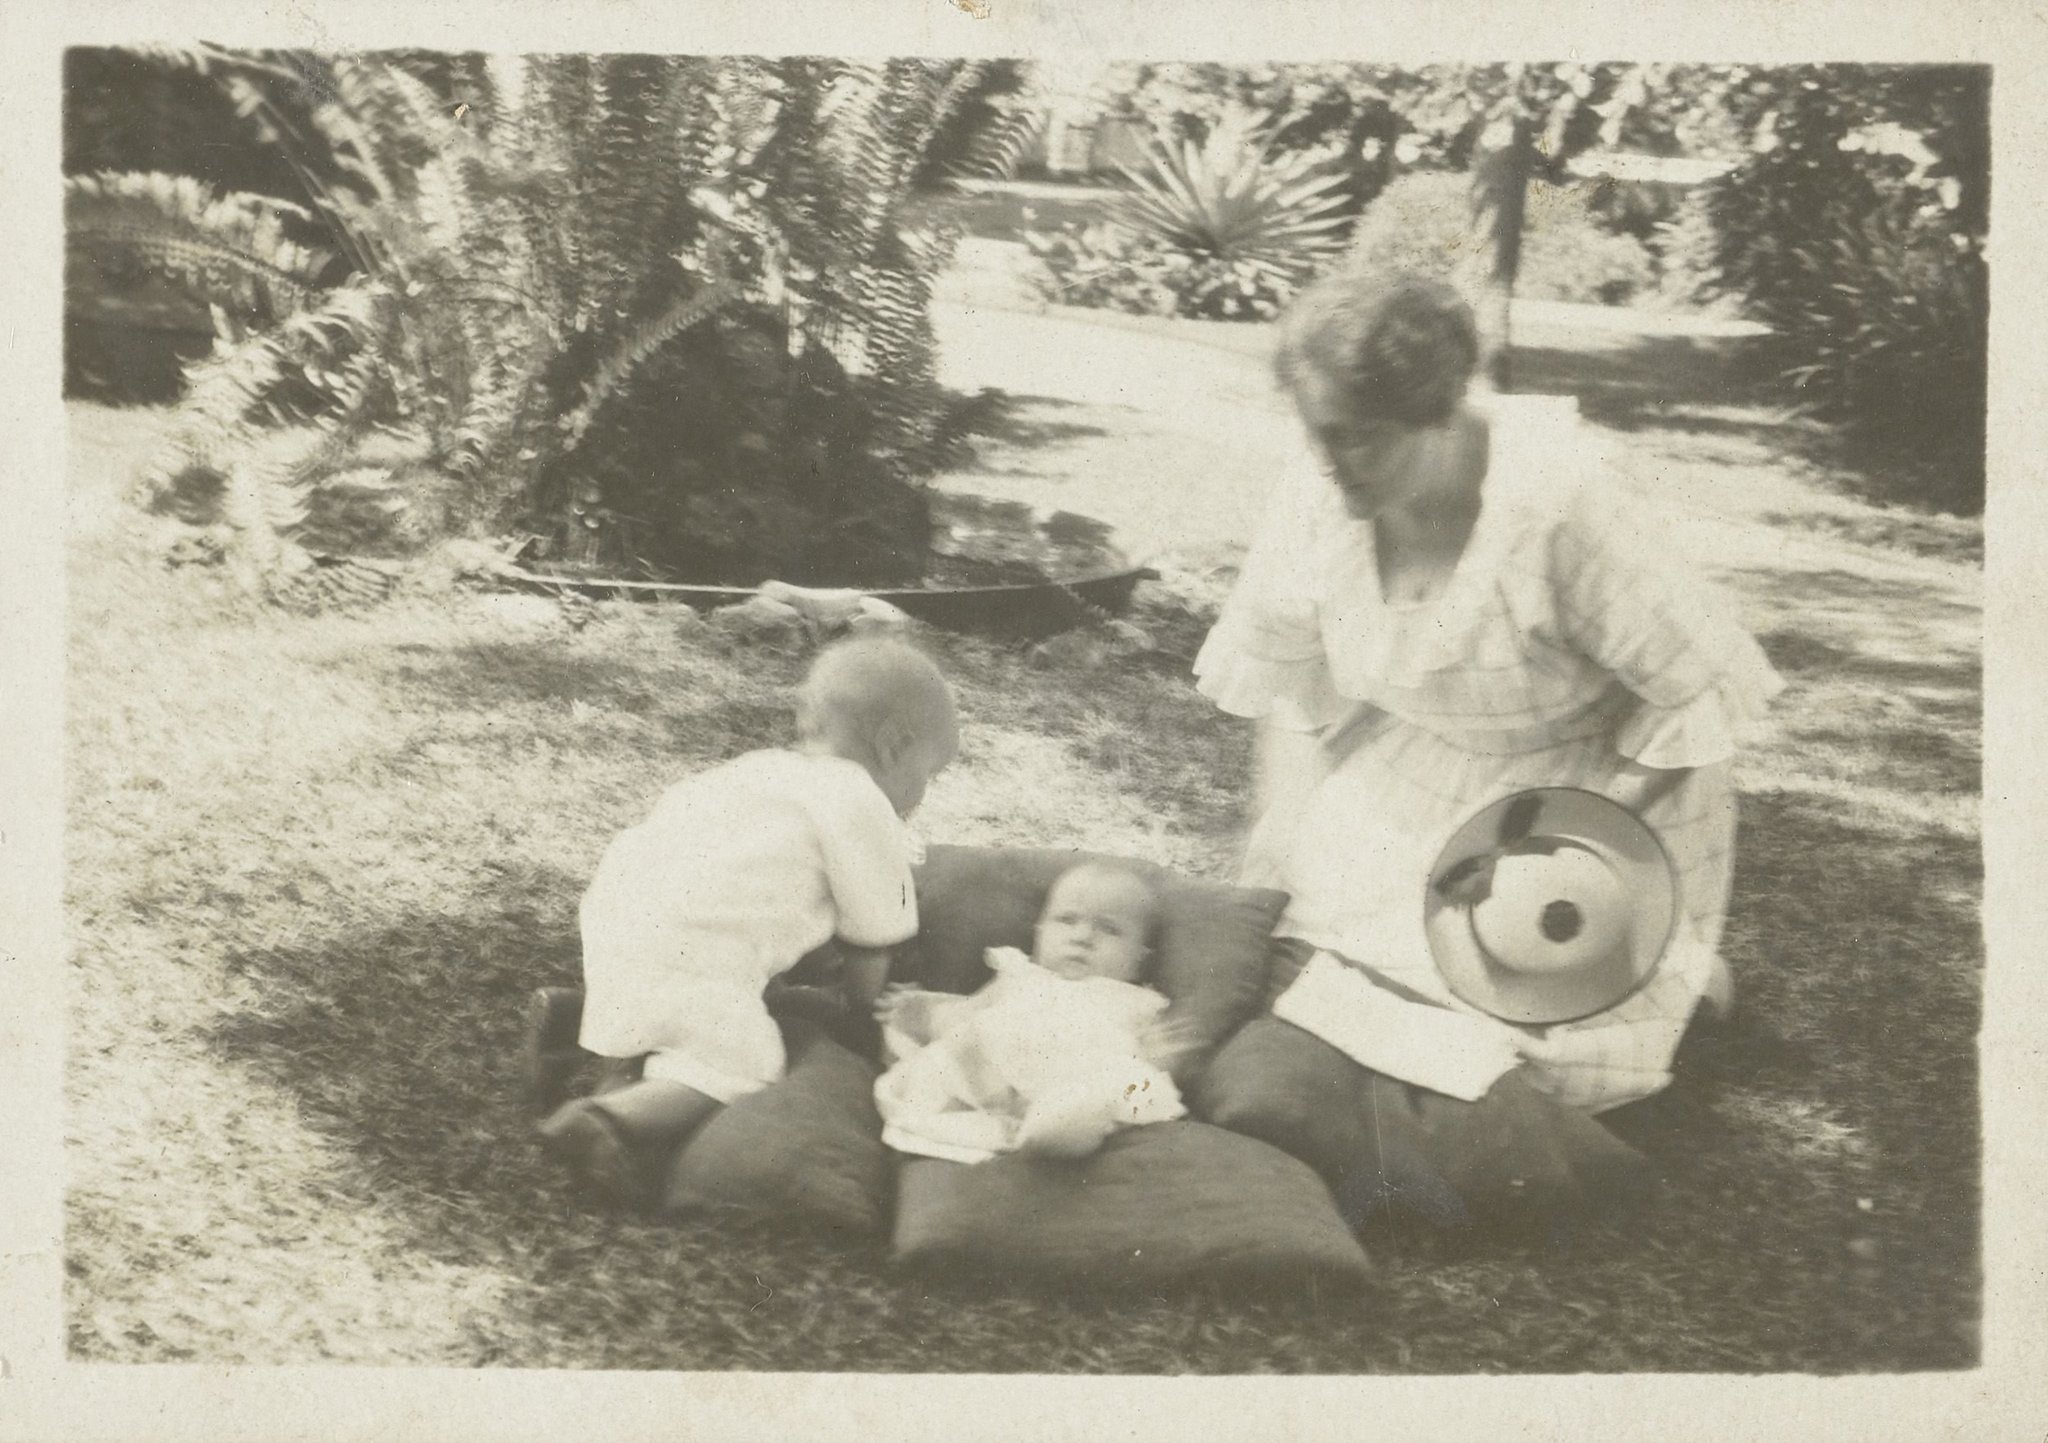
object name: photograph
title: Moeder met twee kleine kinderen in het gras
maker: Anonymous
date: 1912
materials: photographic support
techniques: gelatin silver print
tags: indonesia